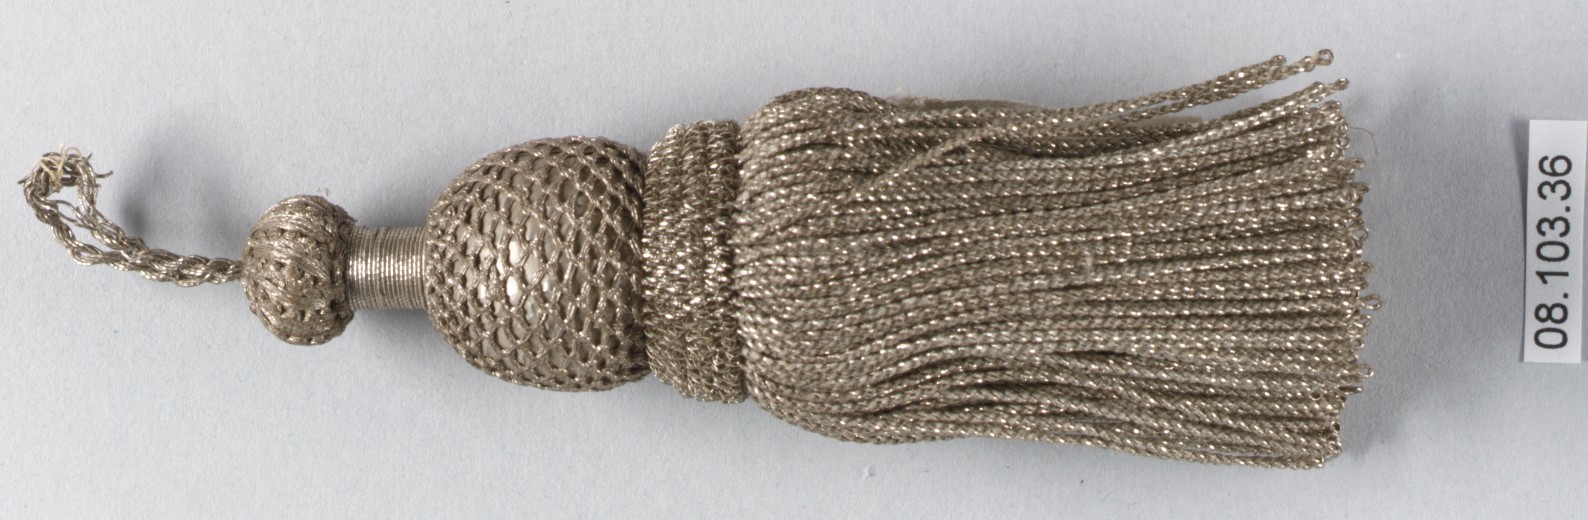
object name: tassel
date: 1801-1833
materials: metal thread